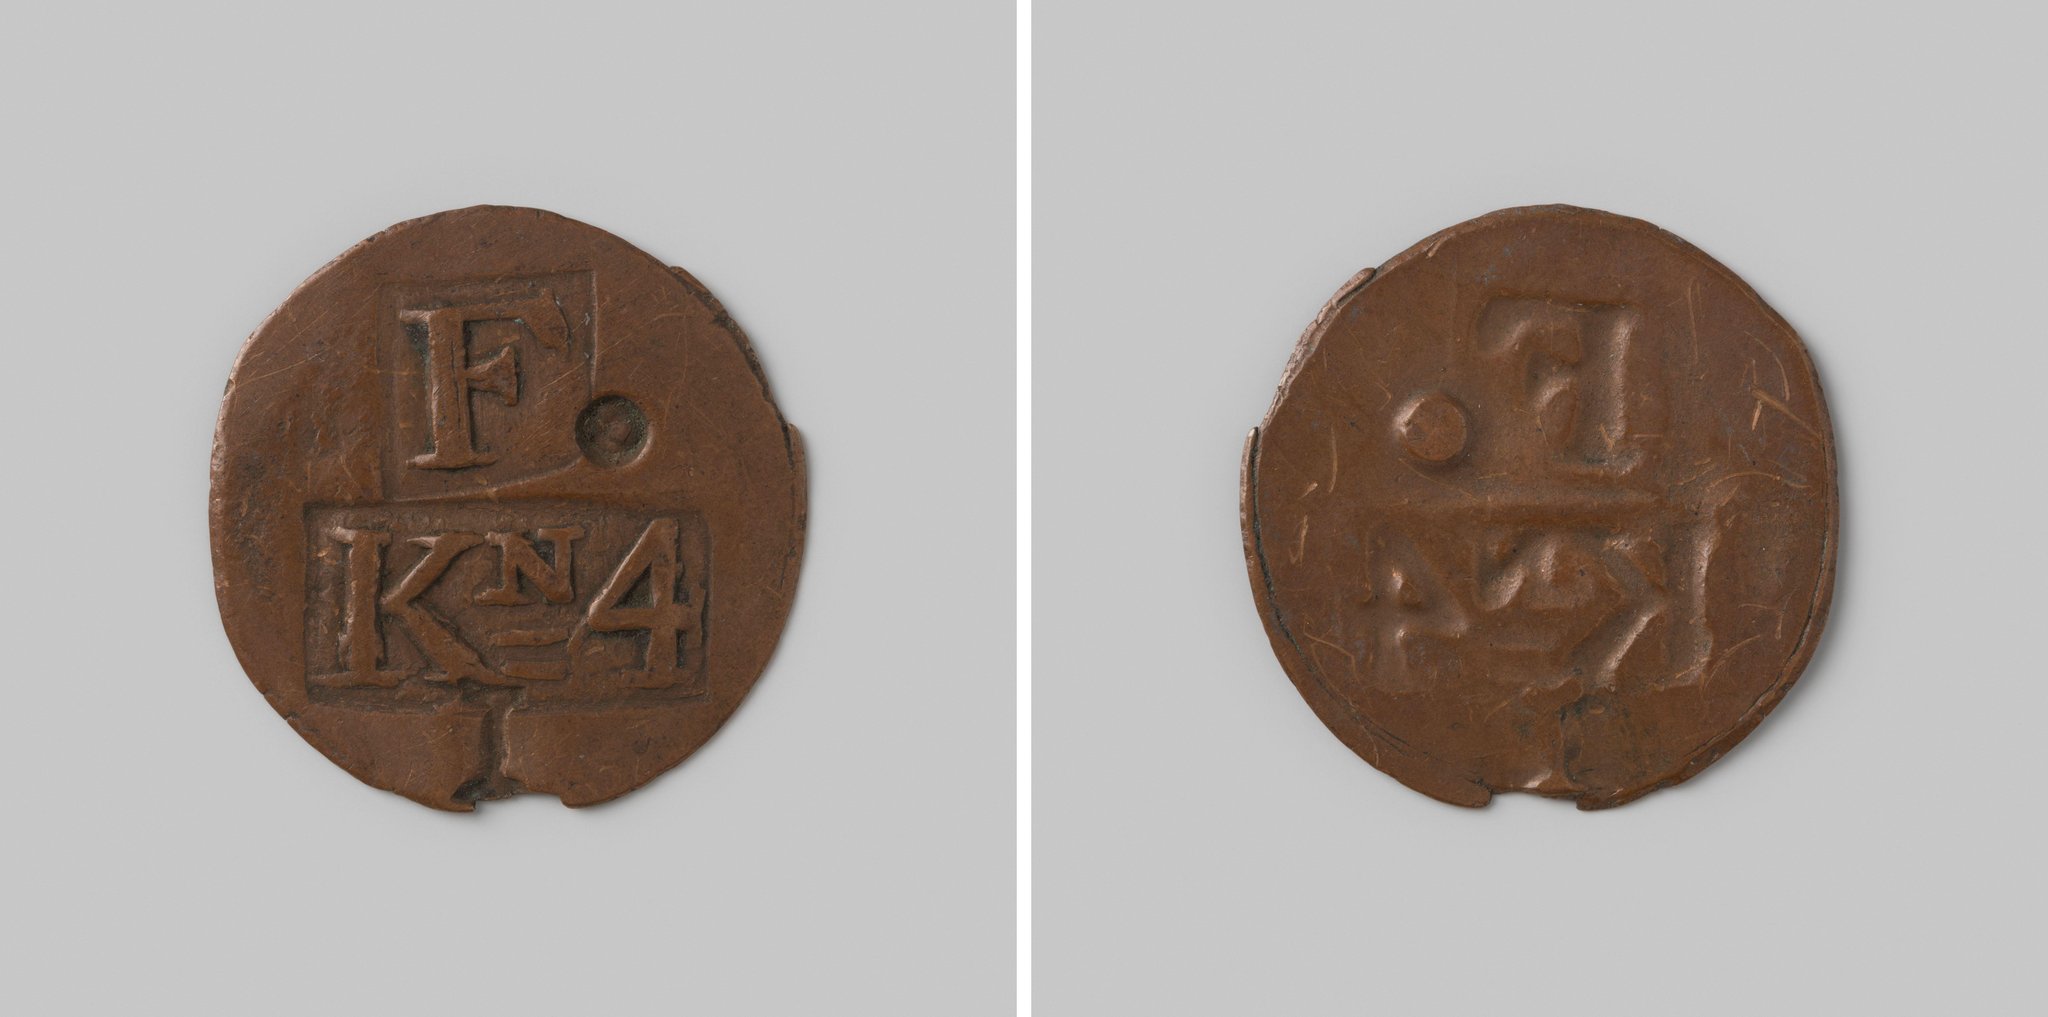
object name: history medal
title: Betaalpenning van 1 cent van Frederiksoord Kn4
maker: Anonymous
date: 1825-1830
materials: copper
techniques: printing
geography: netherlands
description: Rond plaatje koper met vier instempelingen: F - (stip) / Kn4 / I